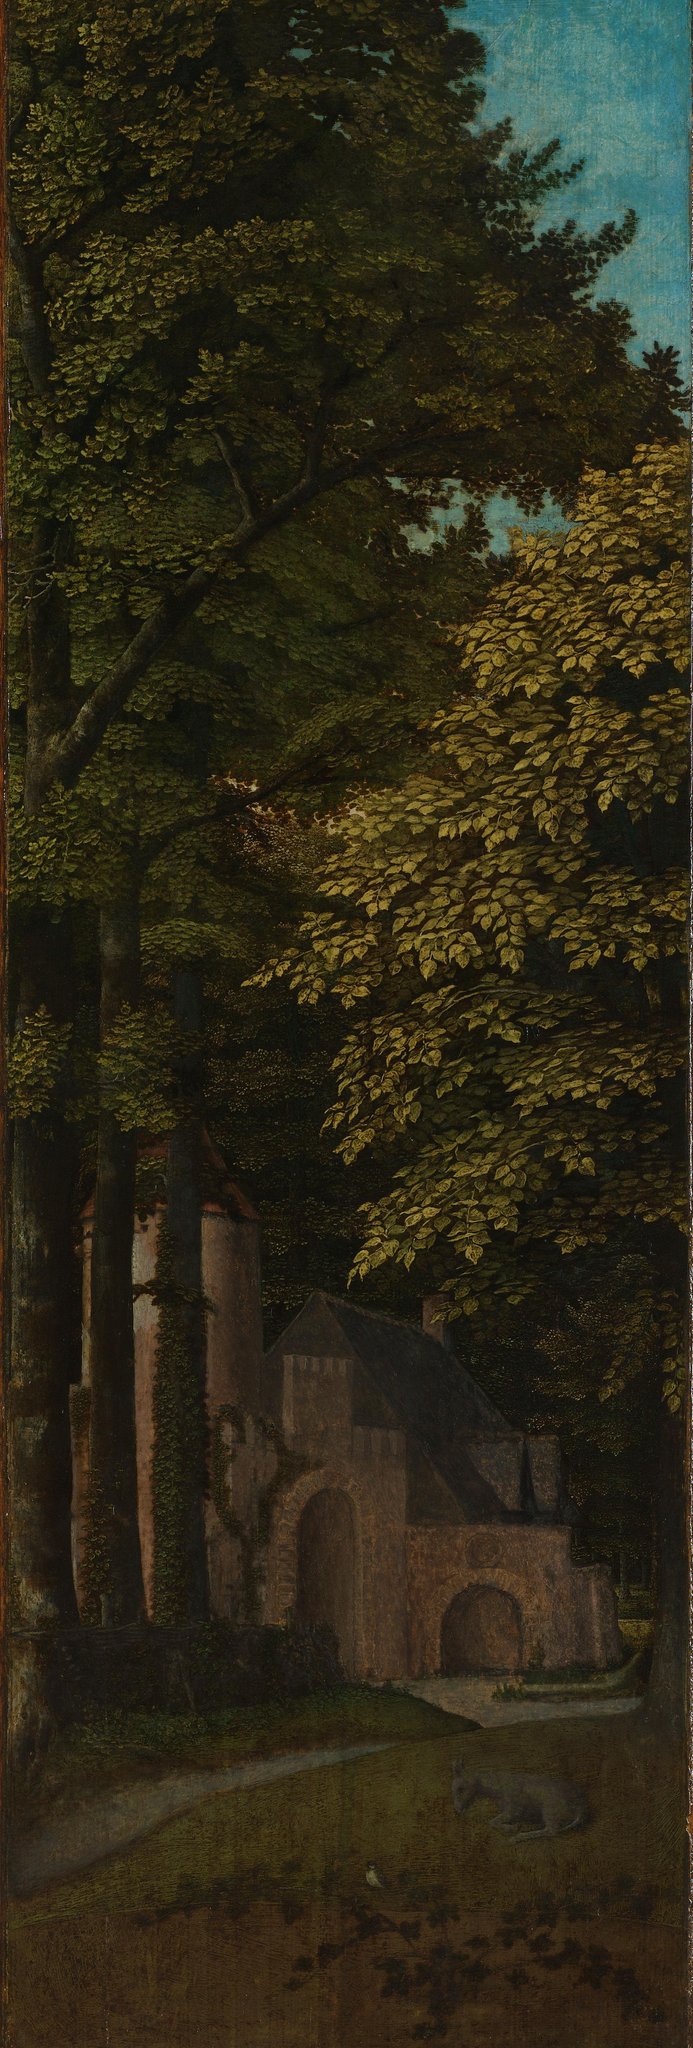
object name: zijpaneel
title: View in a Forest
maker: gerard david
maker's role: draughtsman, painter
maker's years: 1460-1523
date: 1505-1515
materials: oil, panel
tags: forest, wood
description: Bosgezicht. Eén van de twee bosgezichten op de buitenzijde van de twee zijpanelen van een drieluik (zie ook SK-A-3135). Het betreft hier het linkerzijpaneel met een poortgebouw. De binnenzijden van deze zijpanelen en het middenpaneel (met een aanbidding van het kind) bevinden zich in het Metropolitan Musuem of Art in New York.